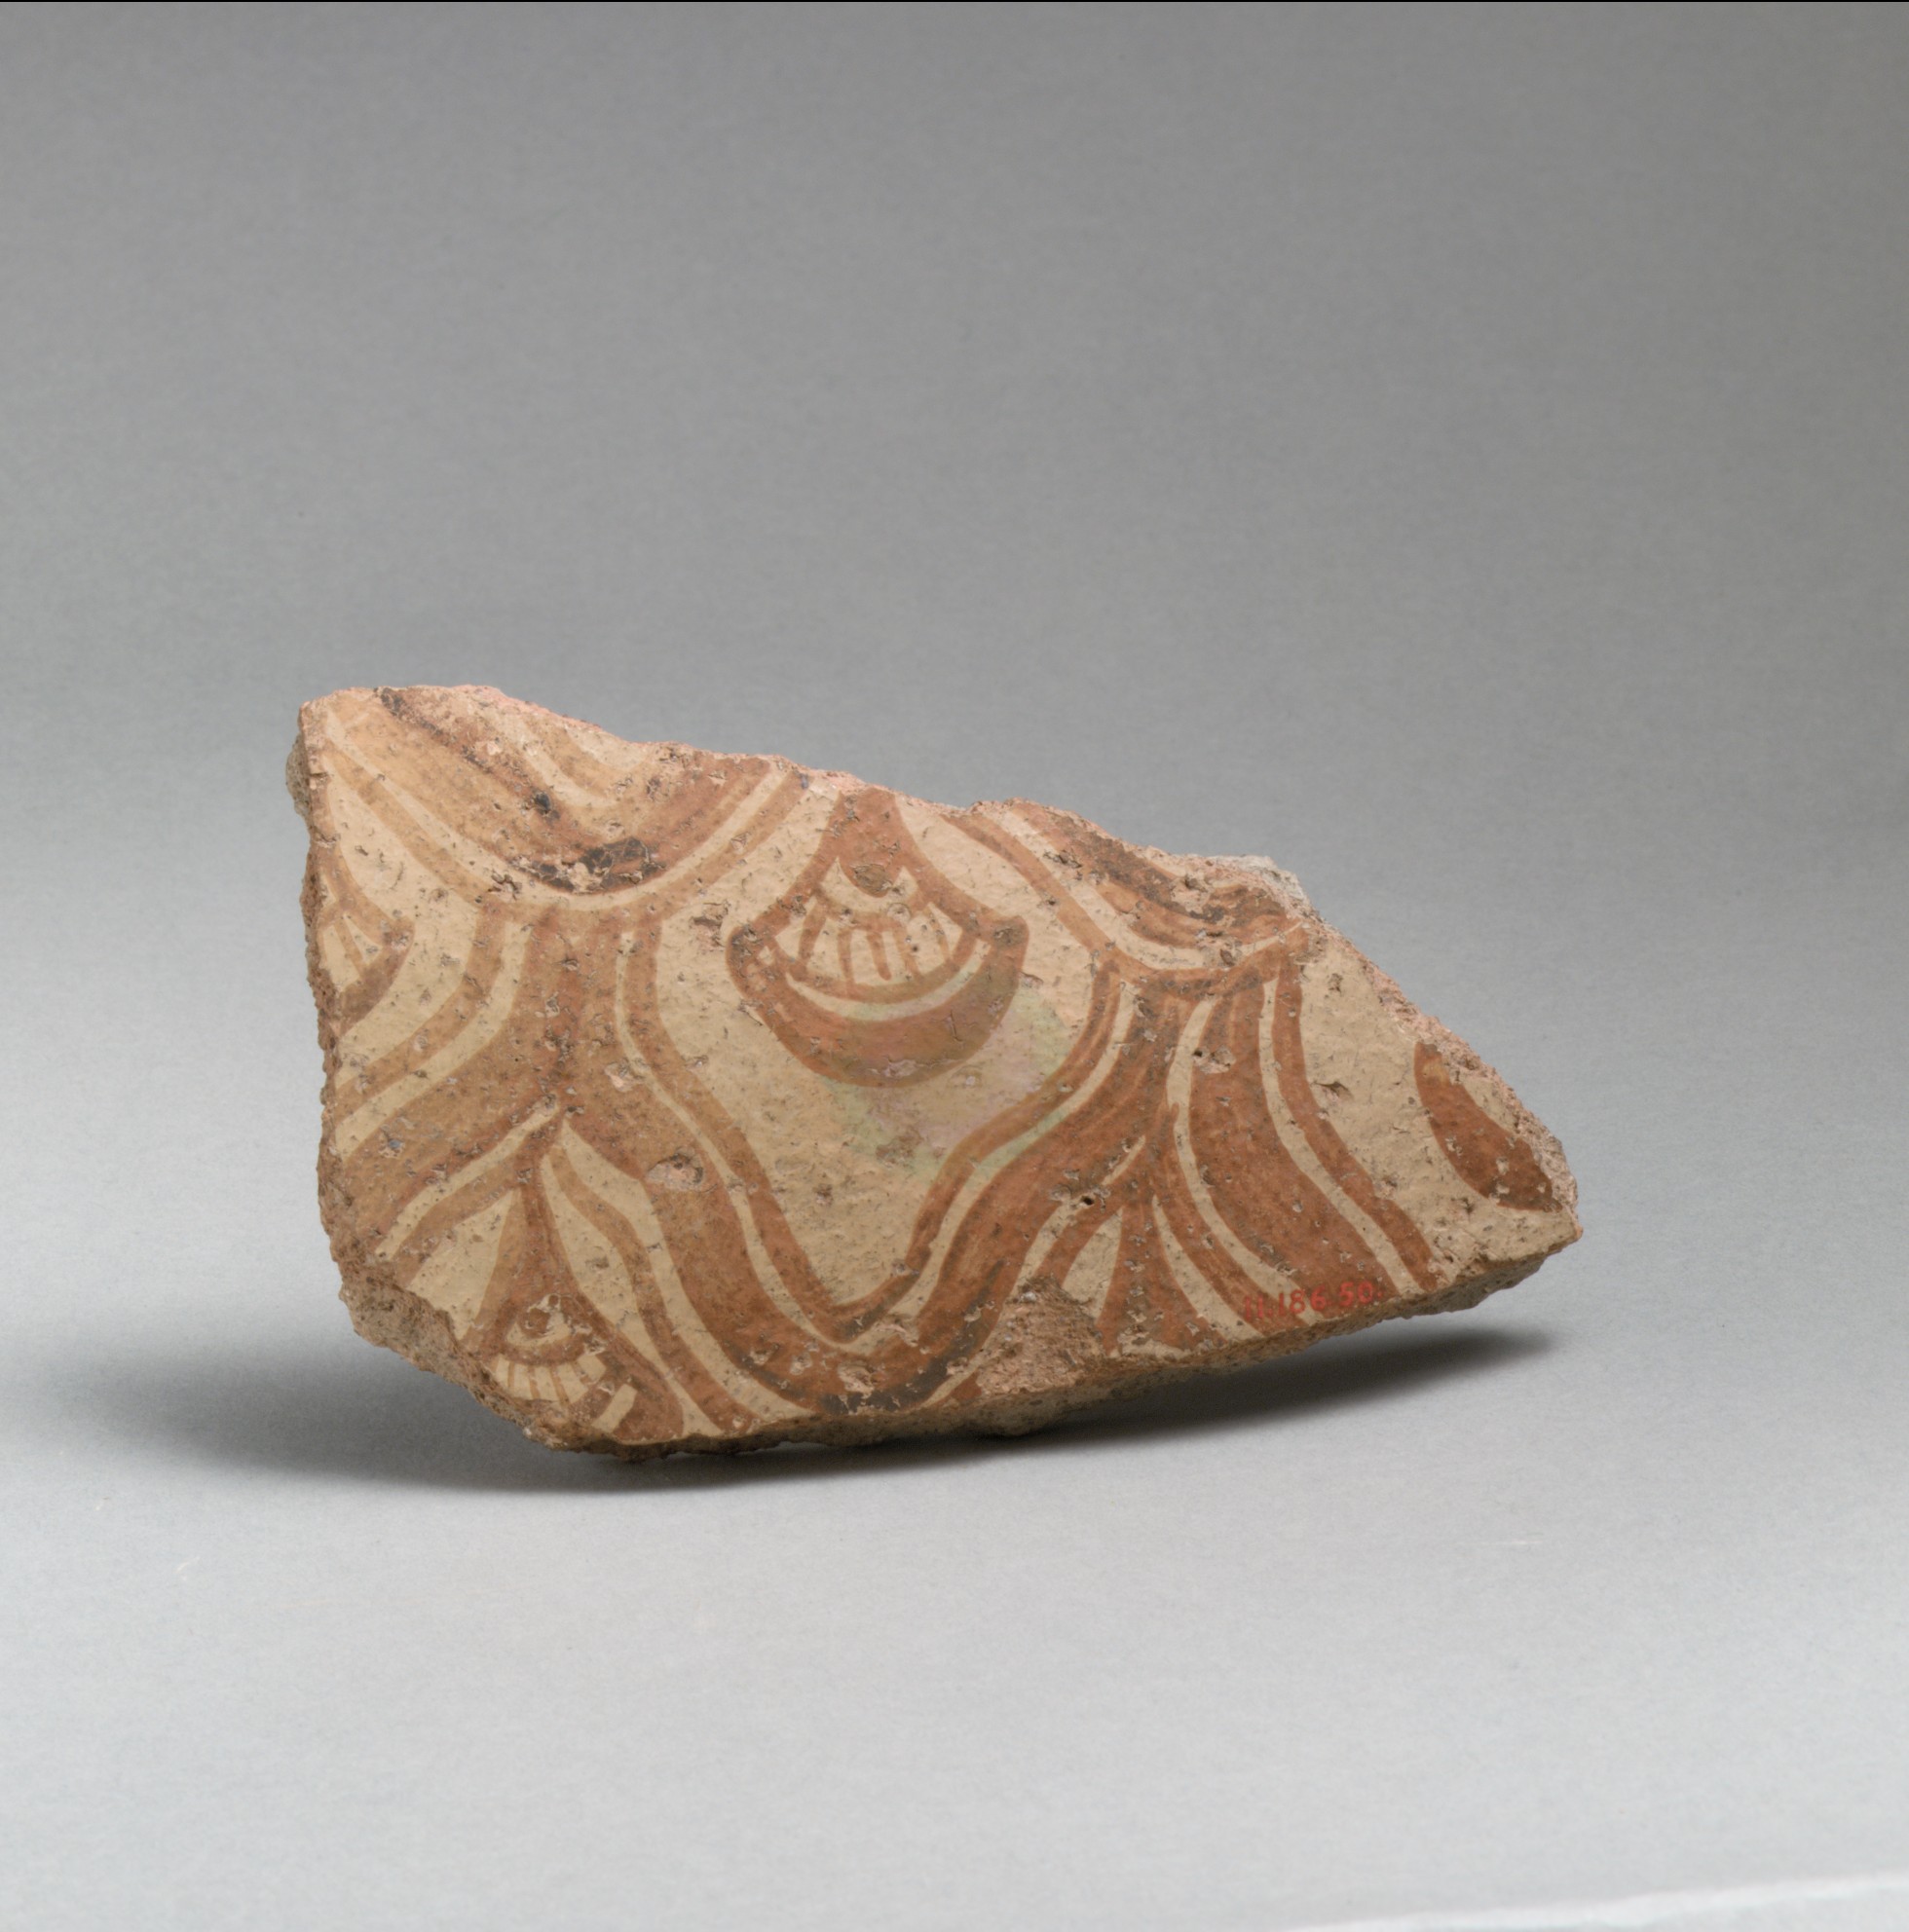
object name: vase fragment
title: Two terracotta fragments of a large jar with reticulated pattern enclosing conventional flowers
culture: minoan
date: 1450-1400 BCE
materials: terracotta